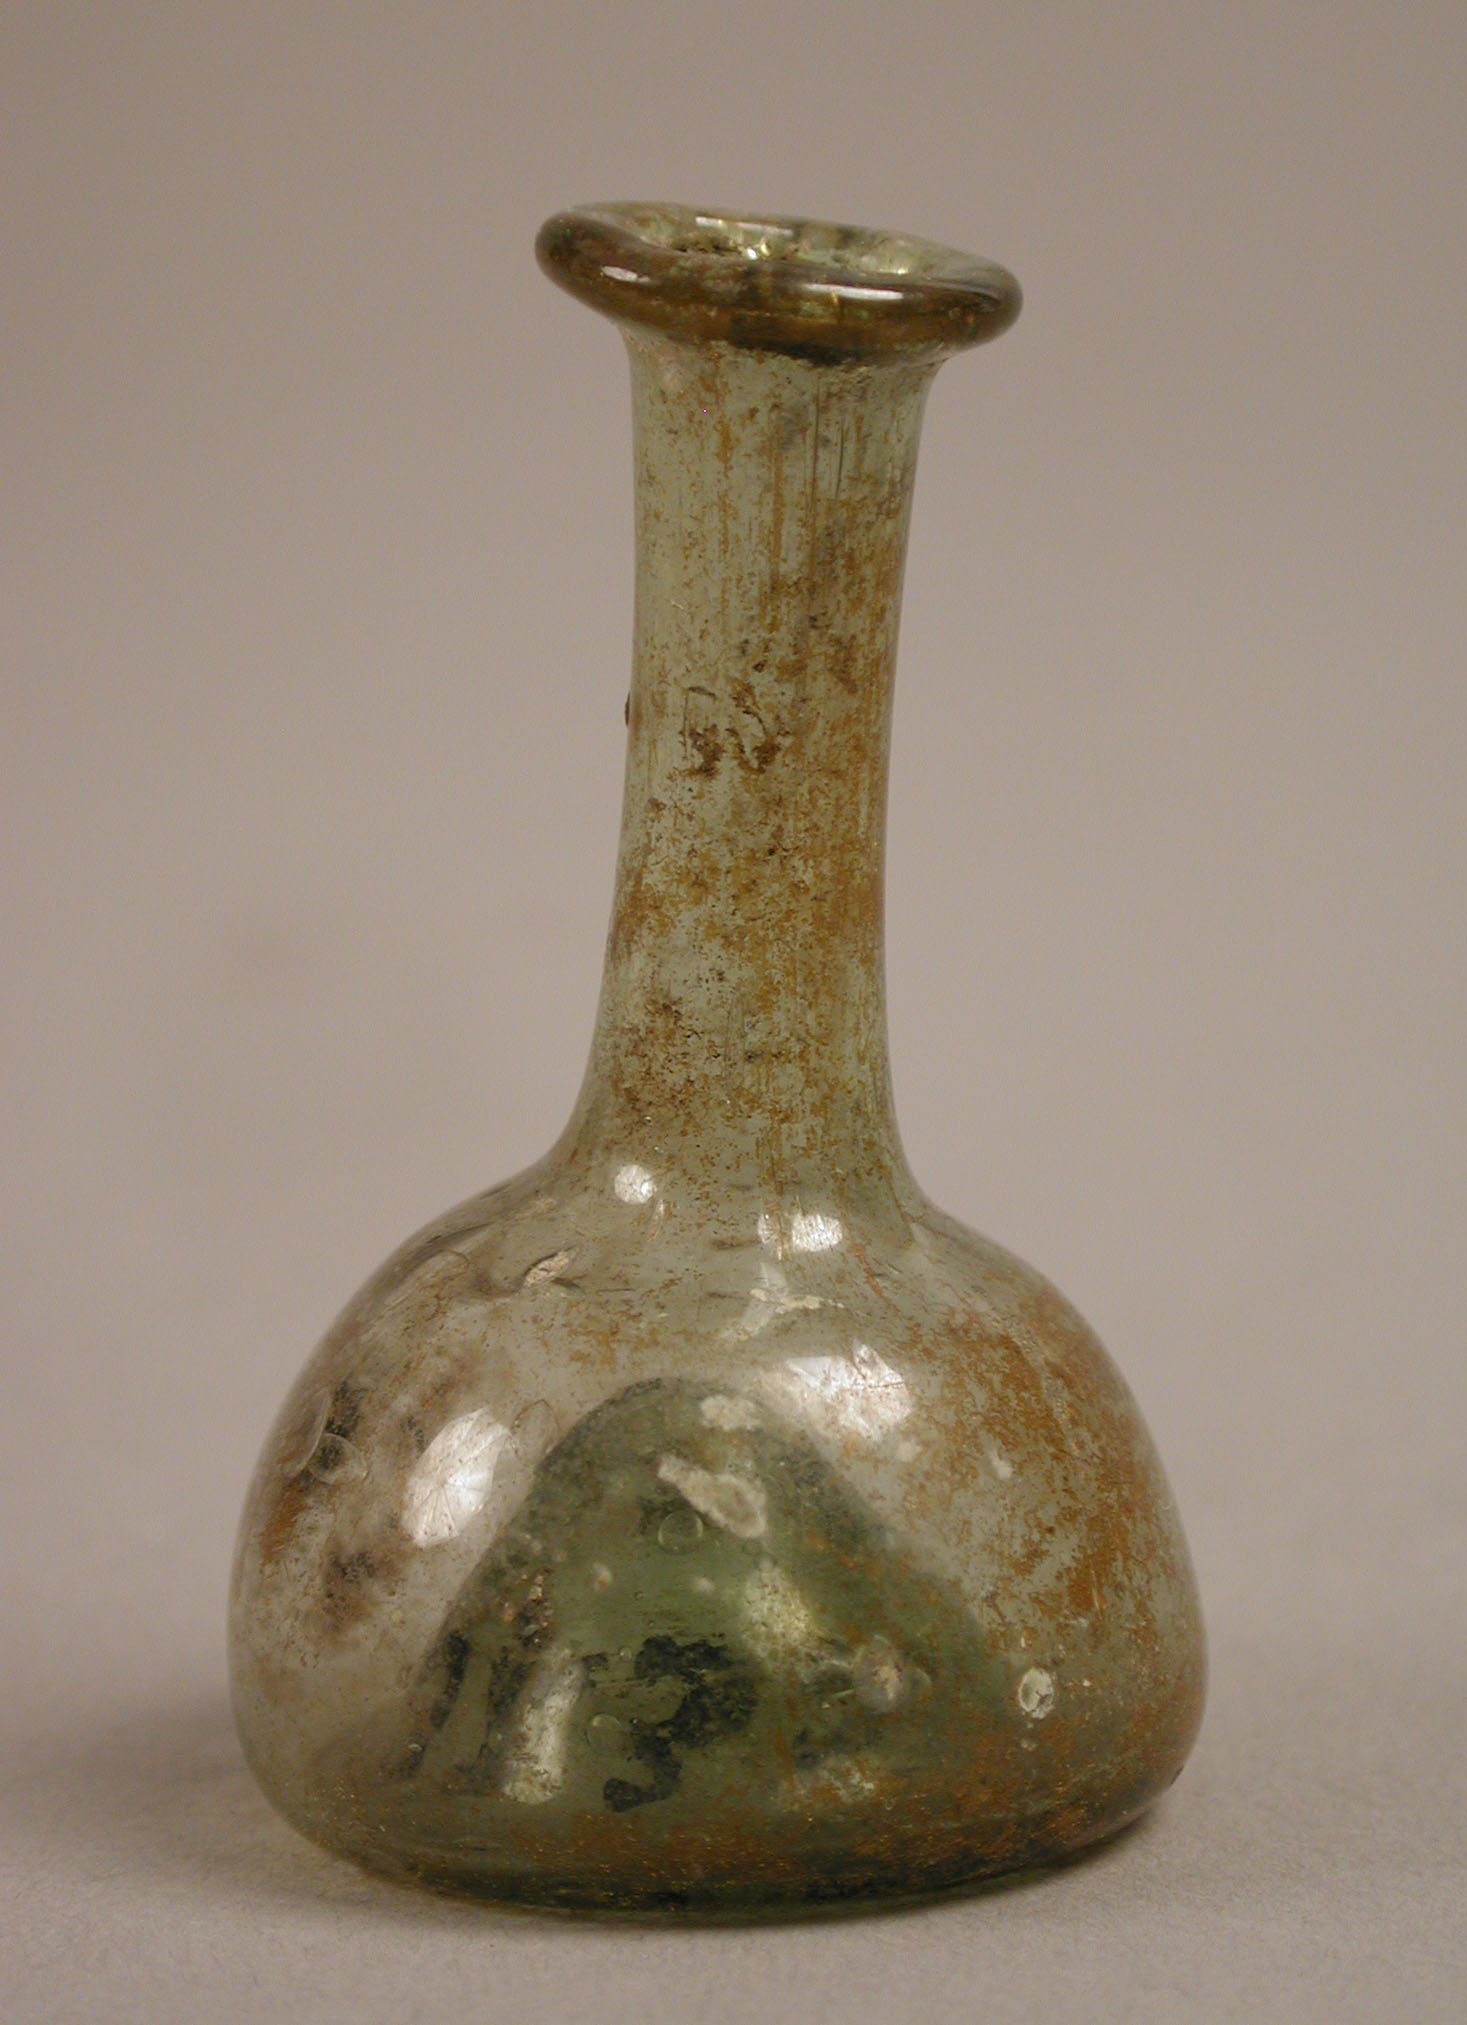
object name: bottle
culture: european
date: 1301-1500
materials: glass